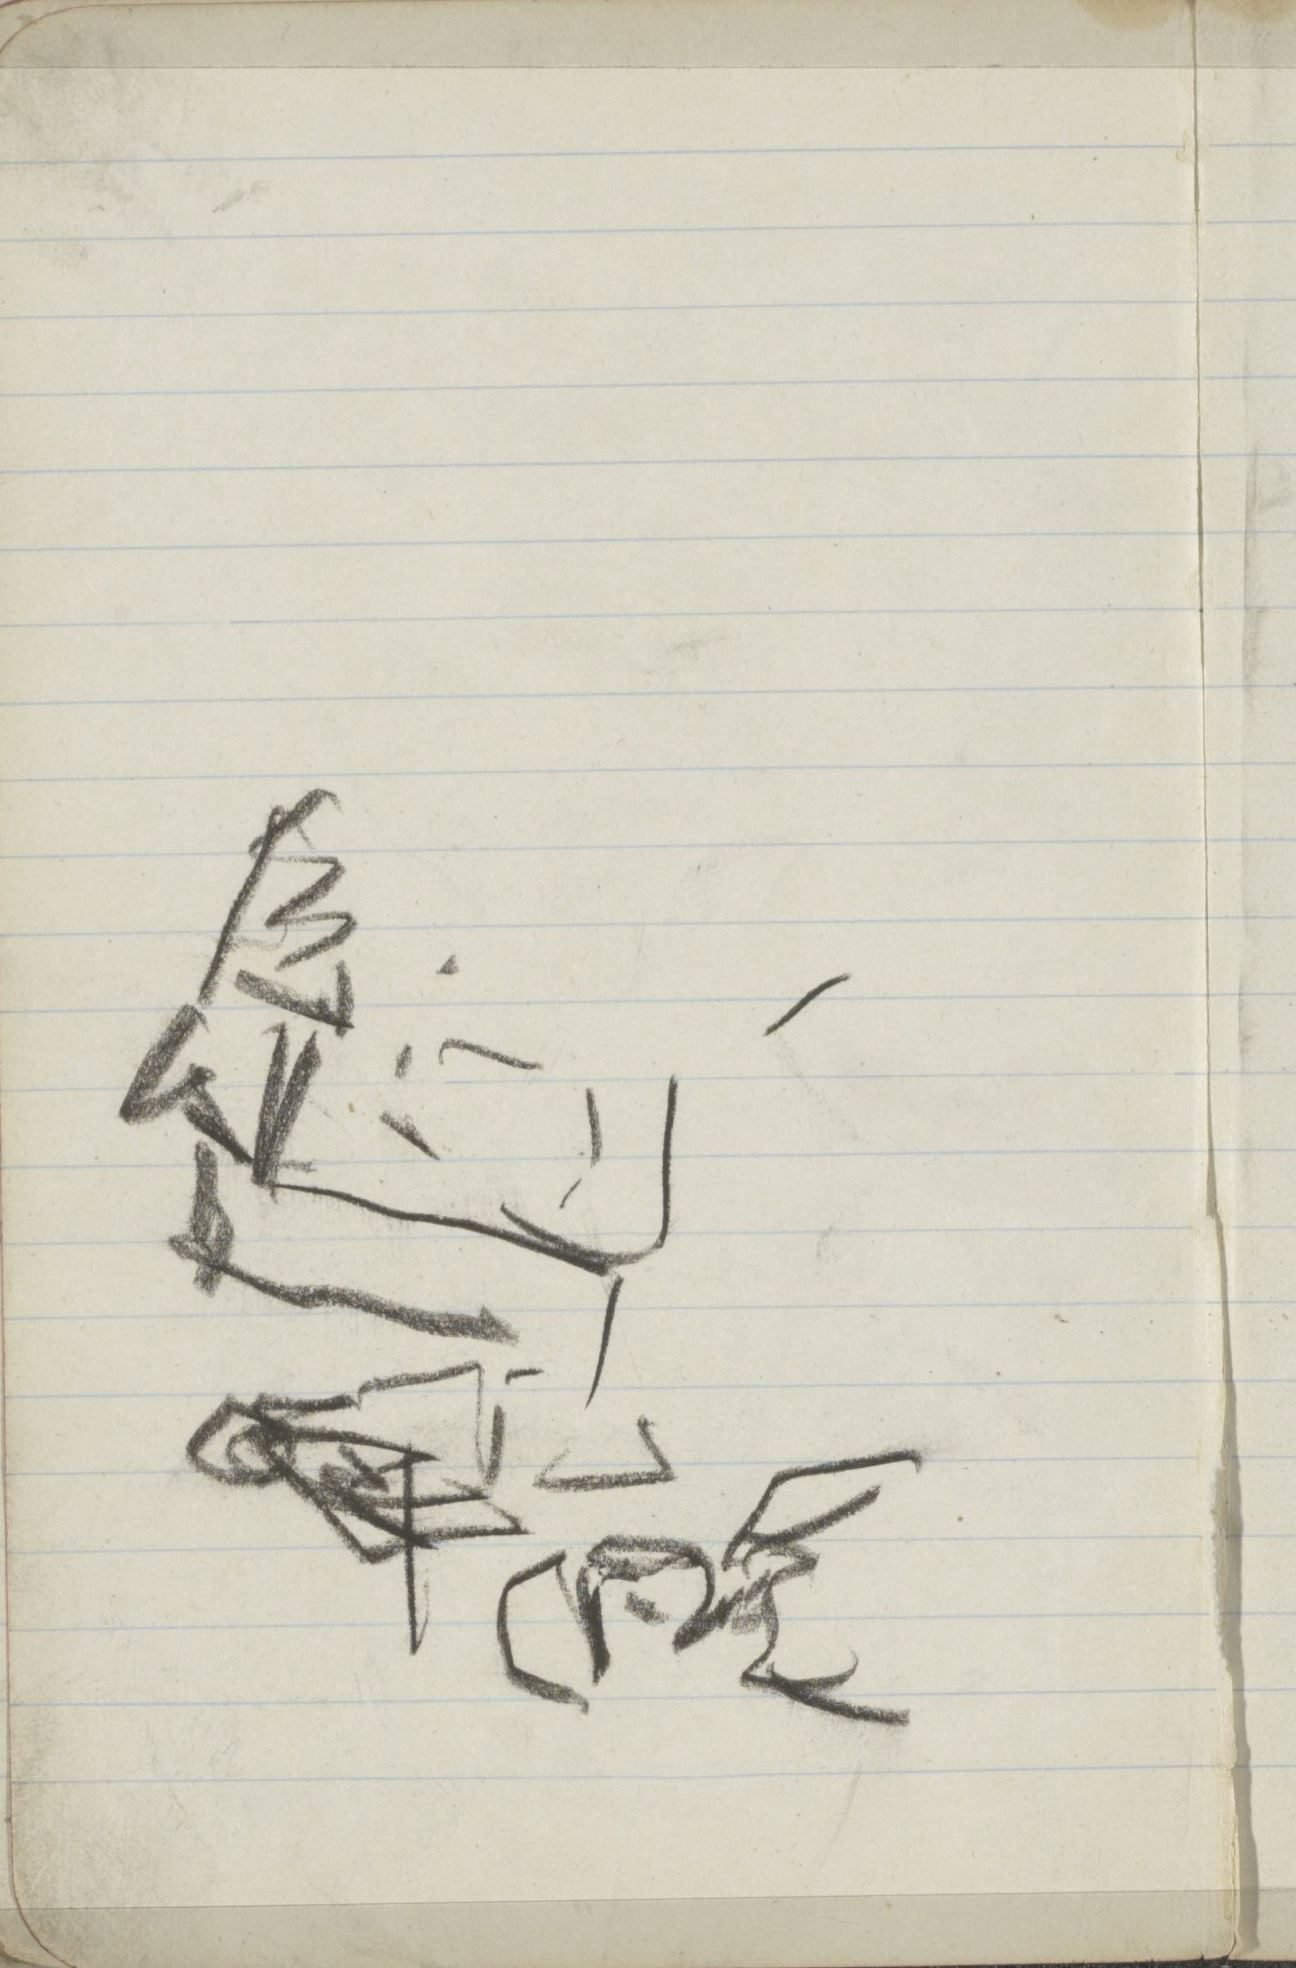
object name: sketchbook leaf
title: Figuren en paarden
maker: george hendrik breitner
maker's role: draughtsman, painter, print maker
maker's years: 1857-1923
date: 1893-1894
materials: chalk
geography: amsterdam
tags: adult man, horse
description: Pagina 48 uit een schetsboek met 36 bladen.